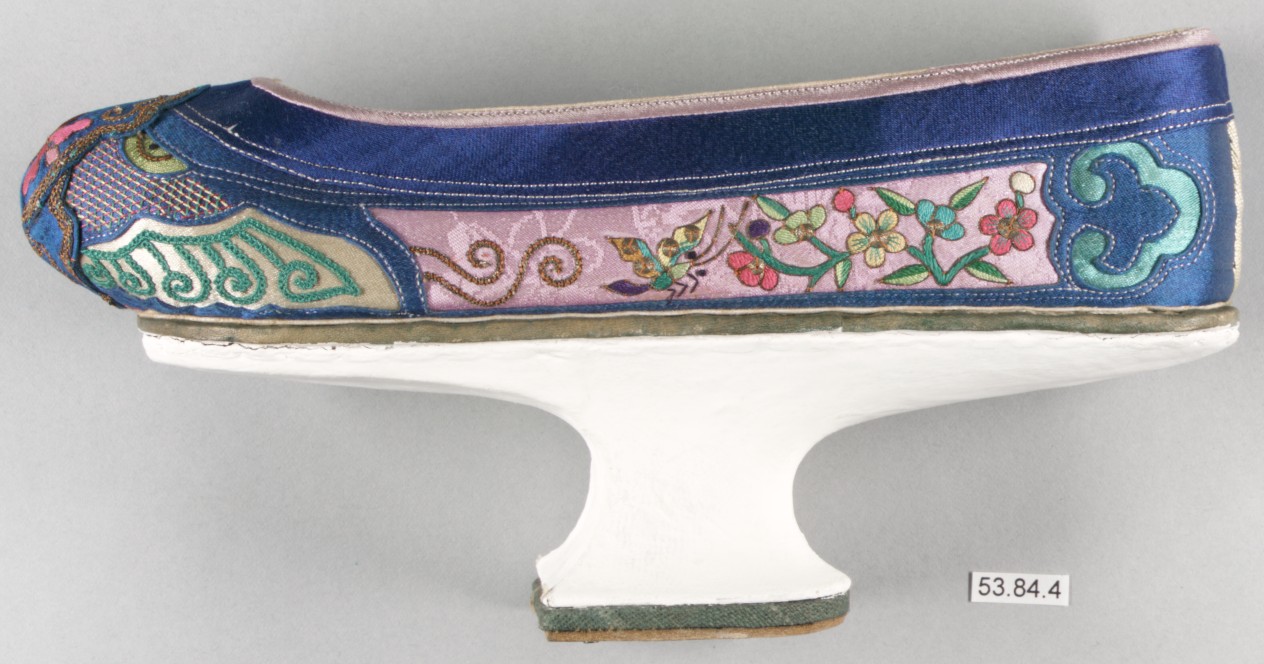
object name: woman's shoe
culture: chinese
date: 1801-2000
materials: leather, metal thread, textile, silk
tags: butterflies,flowers